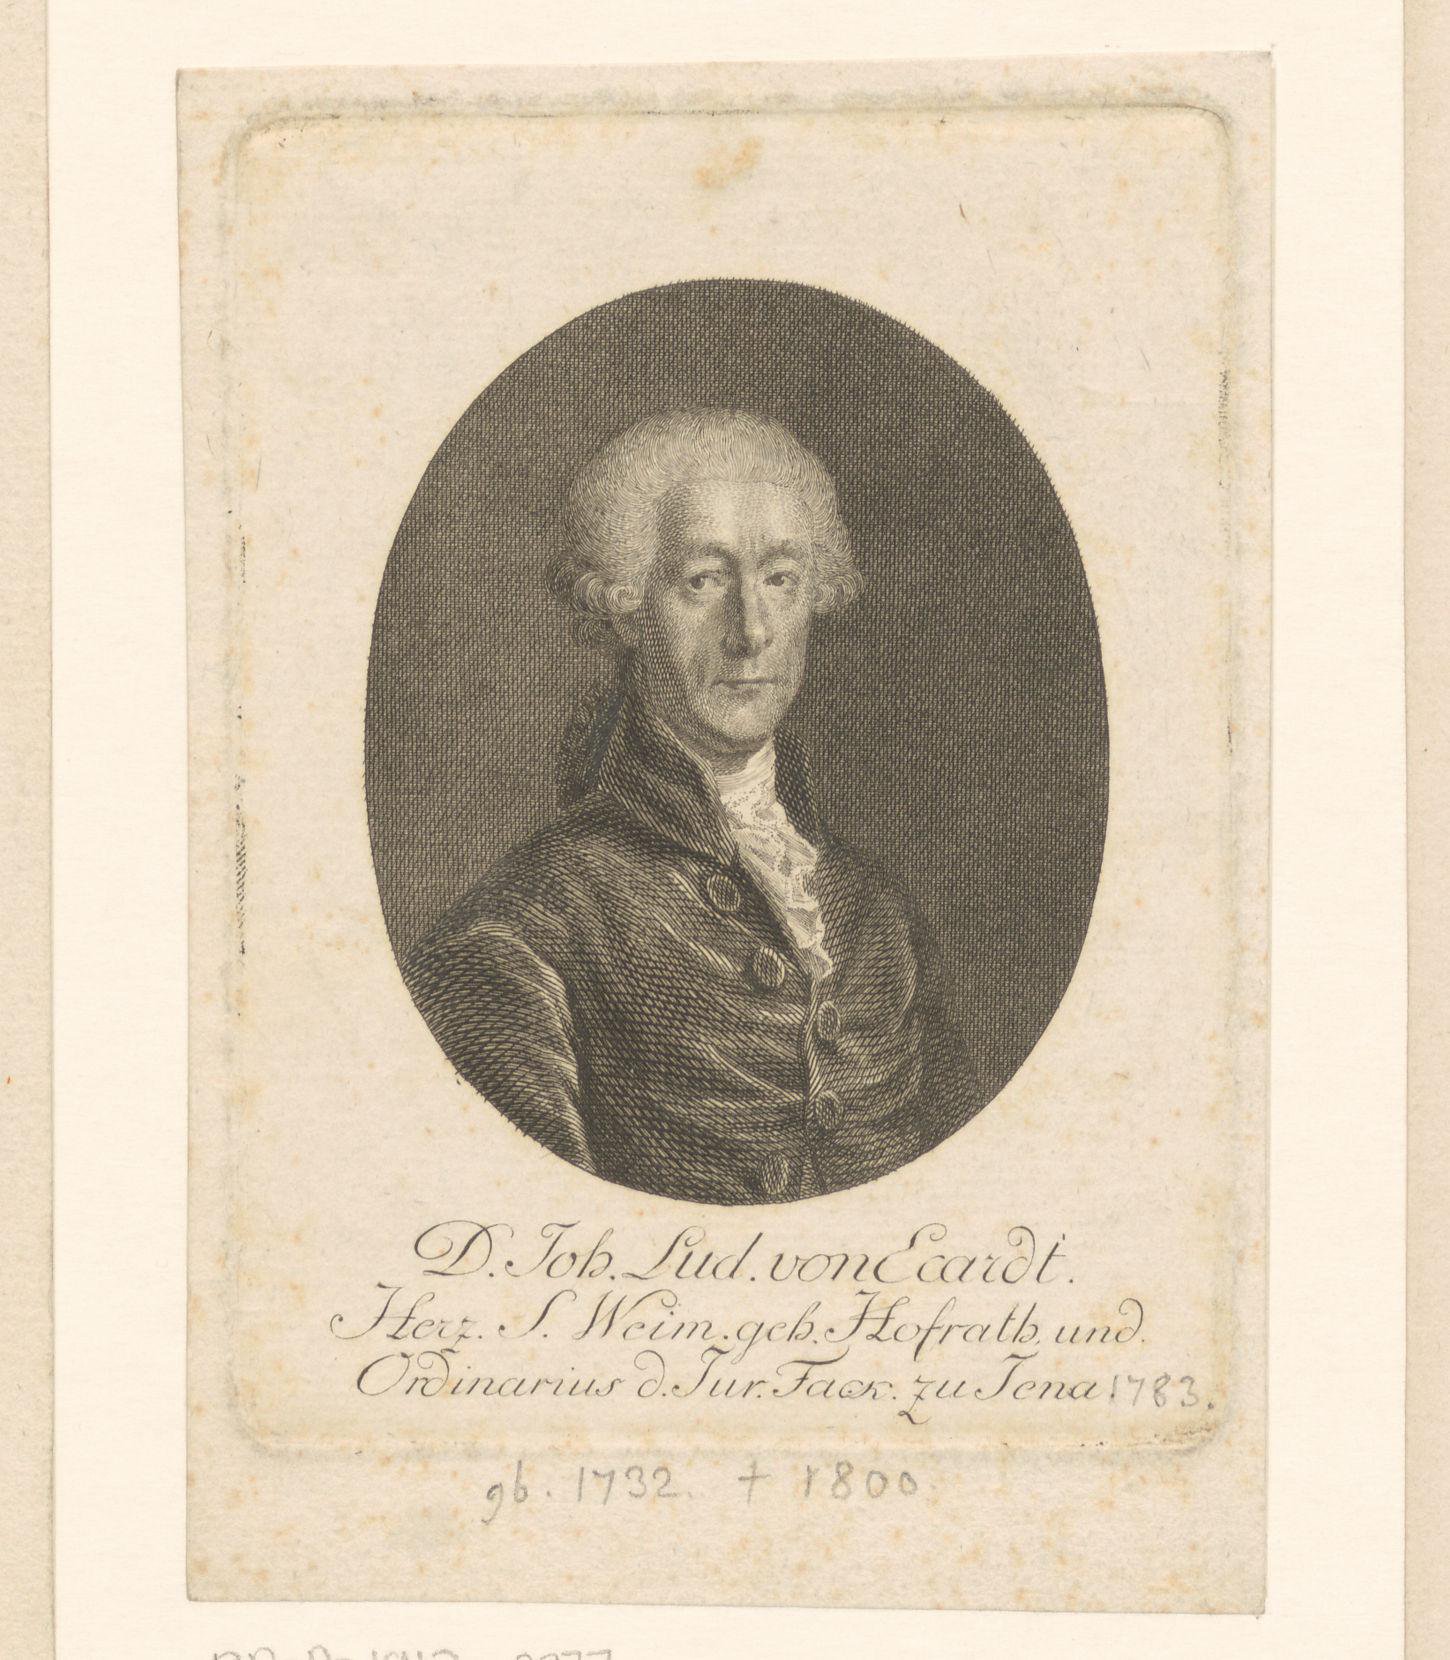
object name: print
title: Portret van Johann Ludwig von Eckardt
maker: ephraïm gottlieb krüger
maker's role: print maker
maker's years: 1756-1834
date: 1794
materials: paper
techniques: engraving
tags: further education (+ portrait of teacher, professor), historical persons, lawyer, attorney at law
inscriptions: collector's mark: Lugt 2228